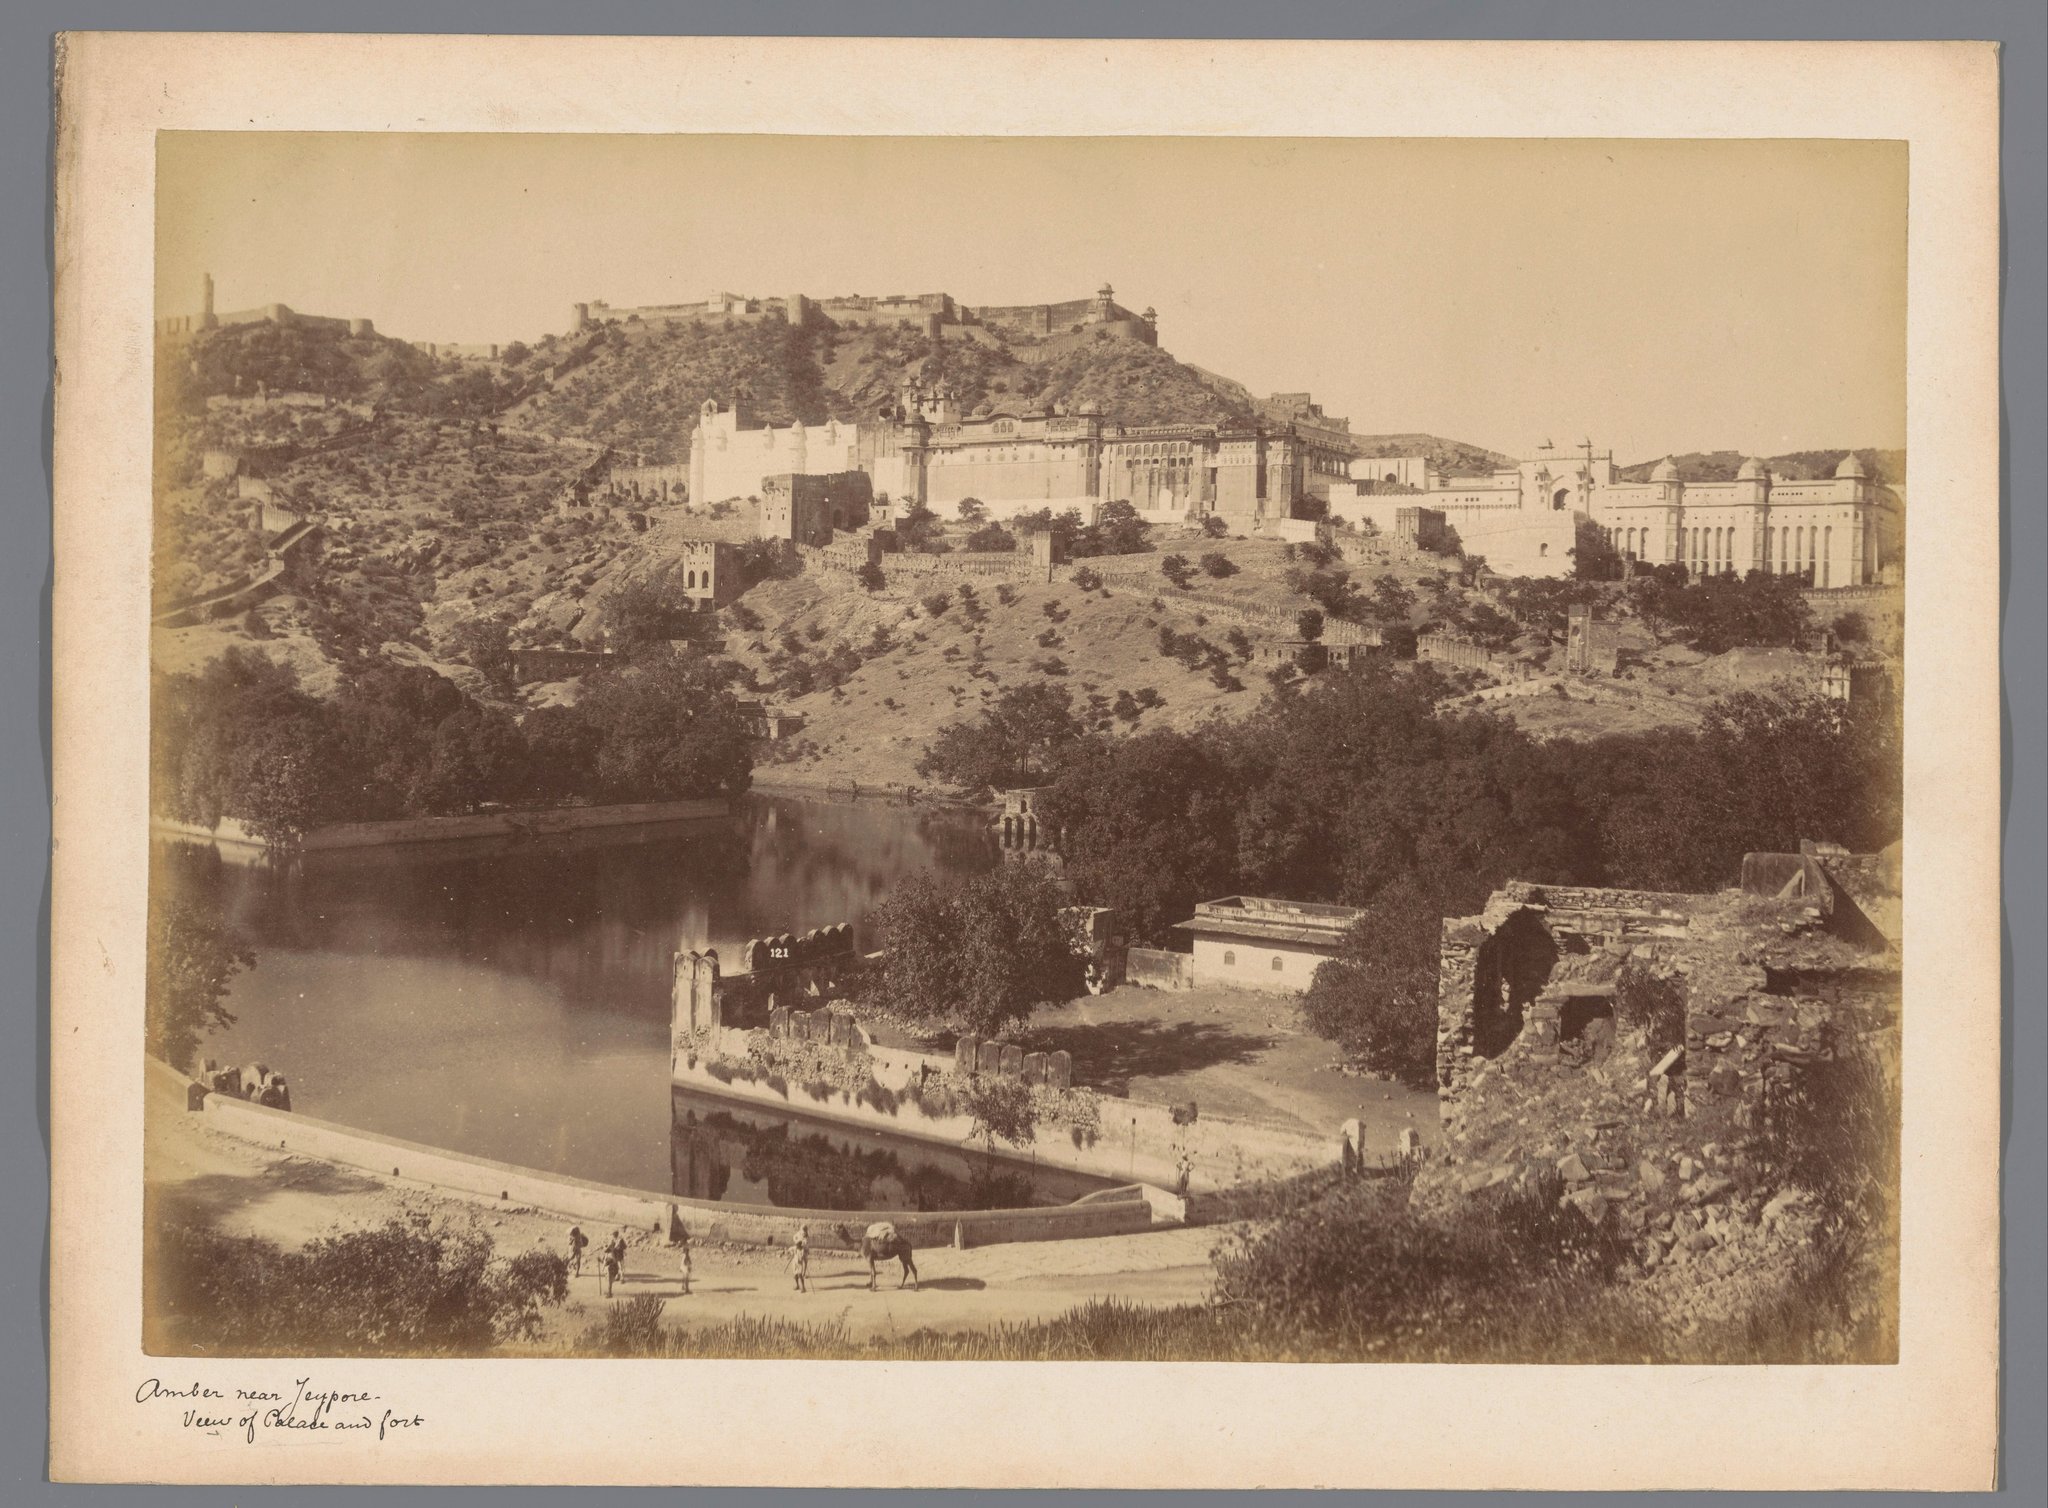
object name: photograph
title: View of the Amer Fort, near Jaipur, Rajasthan, India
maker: Anonymous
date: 1865-1890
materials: cardboard, paper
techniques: albumen print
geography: amer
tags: fortress, palace, lake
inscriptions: title: ‘Amber near Jeypore -/ View of Palace and fort’, number: ‘83’, number: ‘121’